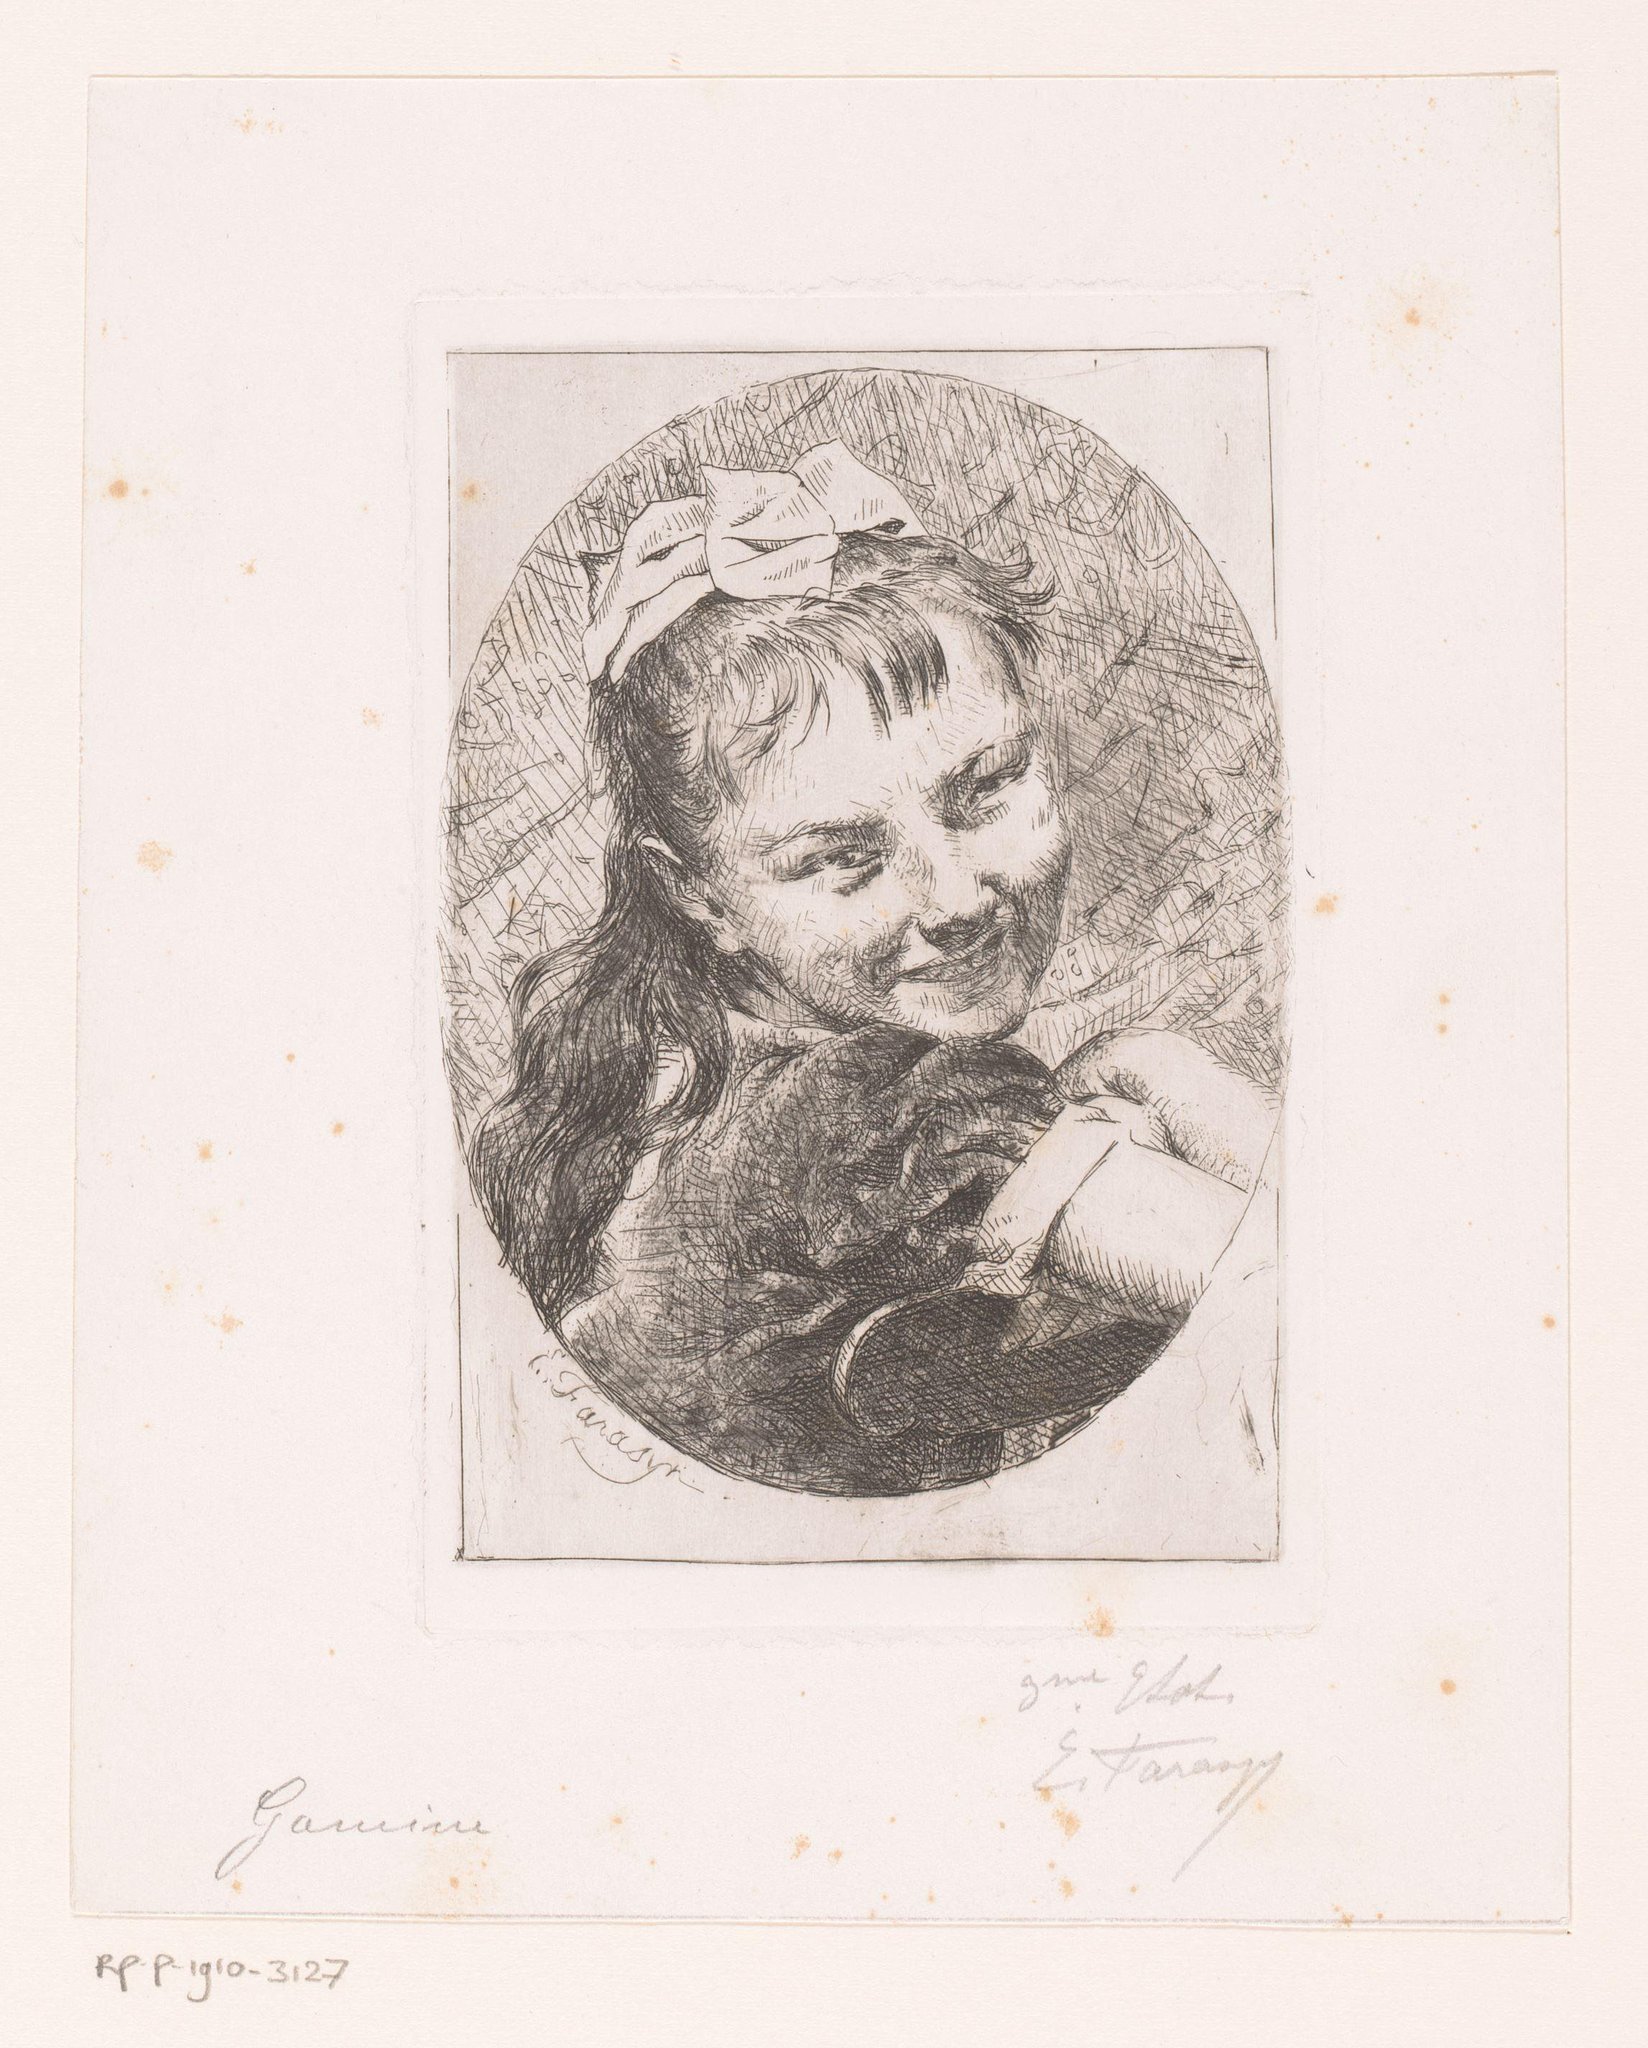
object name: print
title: Portret van een onbekend lachend meisje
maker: edgard farasyn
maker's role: print maker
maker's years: 1858-1938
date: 1868-1910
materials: paper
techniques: etching, intaglio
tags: historical persons, girl (child between toddler and youth)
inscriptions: collector's mark: Lugt 2228, inscription: ‘Gamine; 3me Etat’